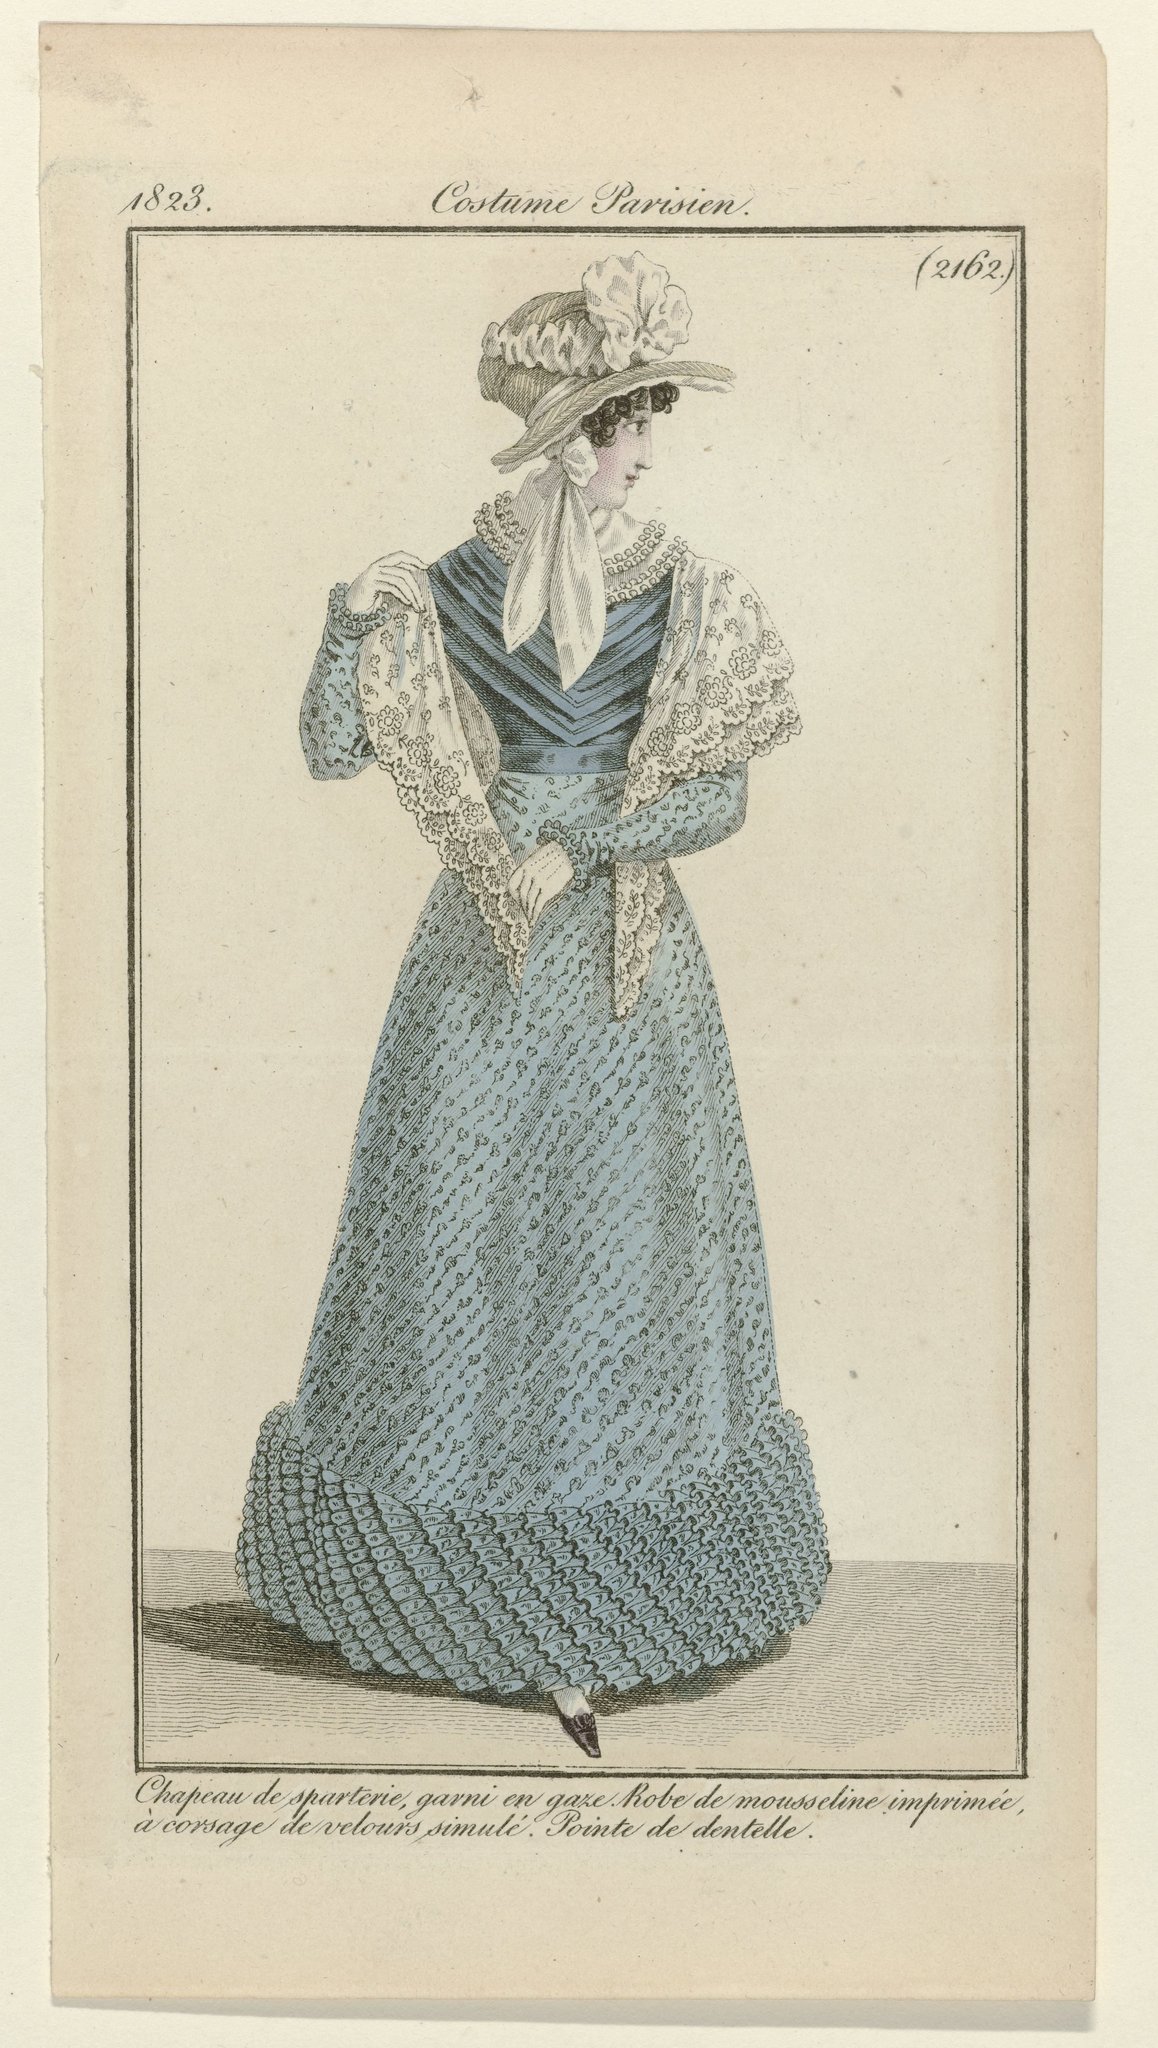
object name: fashion print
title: Journal des Dames et des Modes, Costume Parisien, 30 juin 1823, (2162): Chapeau de sparteri (...)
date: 1823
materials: paper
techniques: engraving, hand coloring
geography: paris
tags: clothing for the upper part of the body (shawl) (+ women's clothes), lace (+ women's clothes), fashion plates, head-gear: hat (+ women's clothes), shoes, sandals (+ women's clothes), gloves, mittens, etc. (+ women's clothes), dress, gown (+ women's clothes)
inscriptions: caption: ‘Chapeau de sparterie, garni en gaze. Robe de mousseline imprimée, à corsage de velours simulé. Pointe de dentelle.’, title: ‘Costume Parisien.’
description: Vrouw met op het hoofd een hoed van 'sparterie' (gevlochten plantenvezels) versierd met tule. Zij draagt een japon van bedrukte mousseline met een lijfje van 'velours simulé'. Verdere accessoires: driehoekige doek van kant, handschoenen, schoen met vierkante neus. De prent maakt deel uit van het modetijdschrift Journal des Dames et des Modes, uitgegeven door Pierre de la Mésangère, Parijs, 1797-1839.